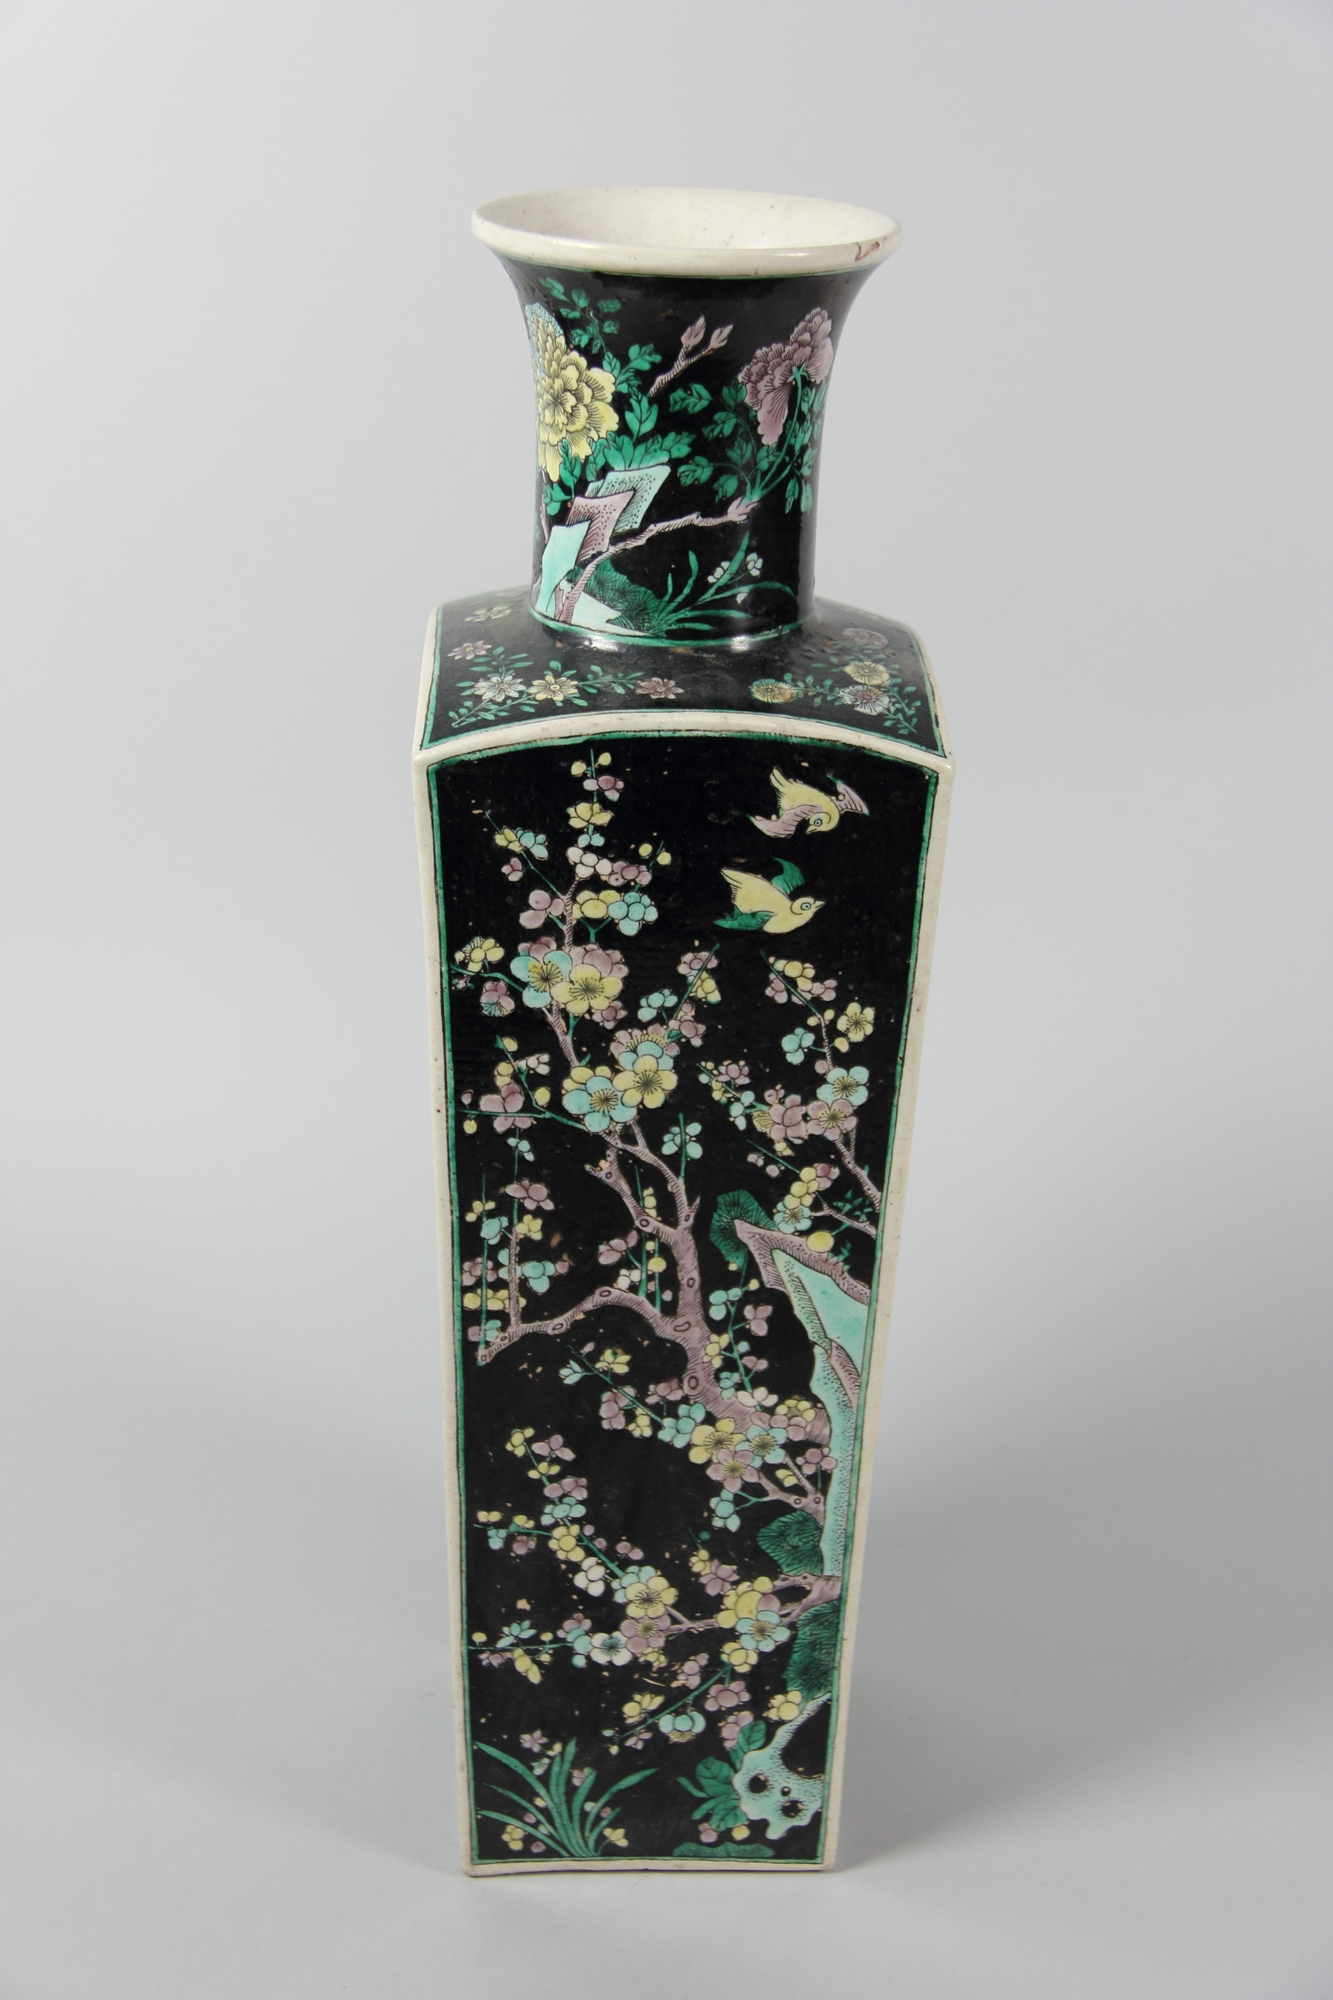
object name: vase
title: Square vase with scenes of four seasons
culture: chinese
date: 1667-1733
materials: enamel, porcelain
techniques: painting, polychrome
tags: birds,flowers